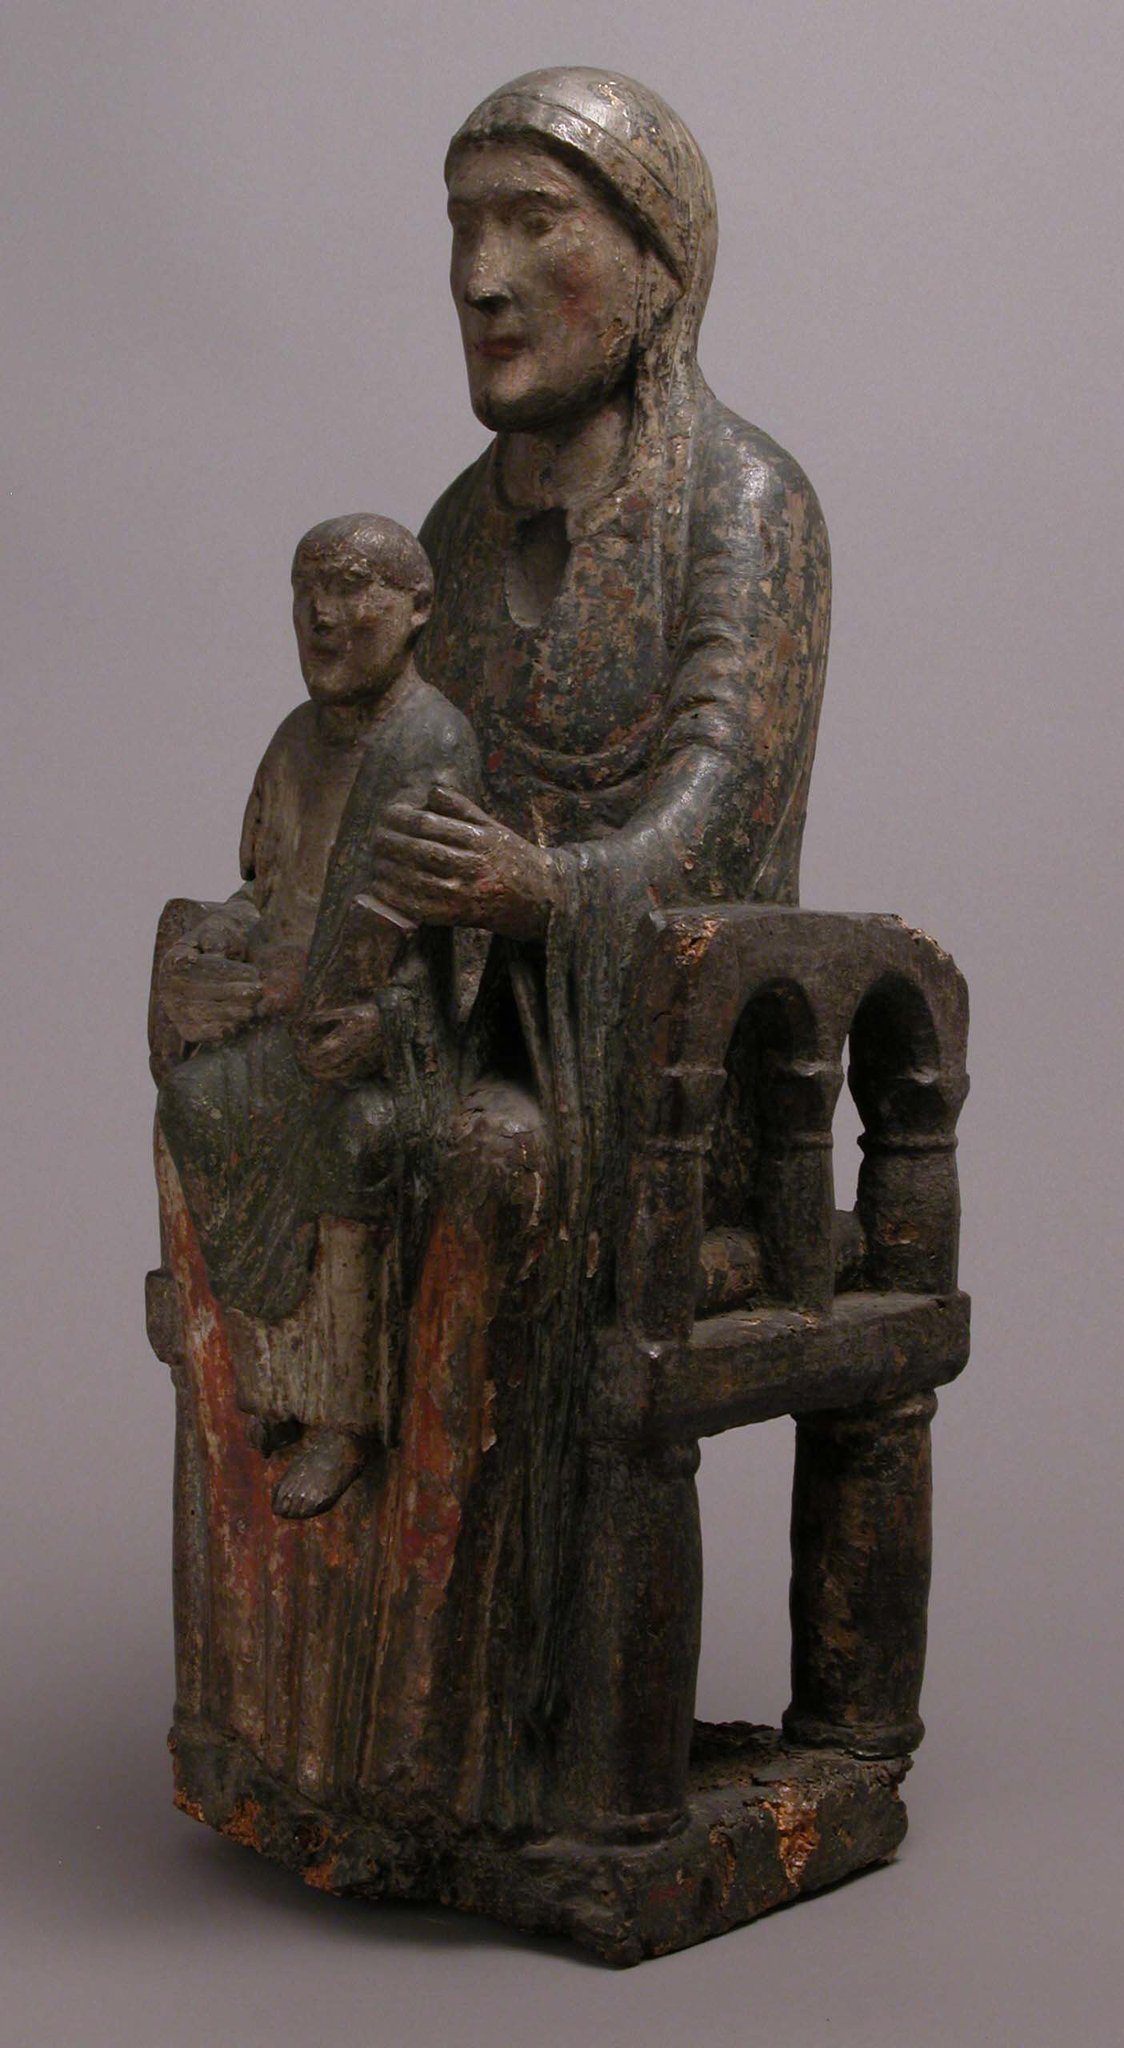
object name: statuette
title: Virgin and Child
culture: french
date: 1151-1200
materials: wood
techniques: gilding, painting